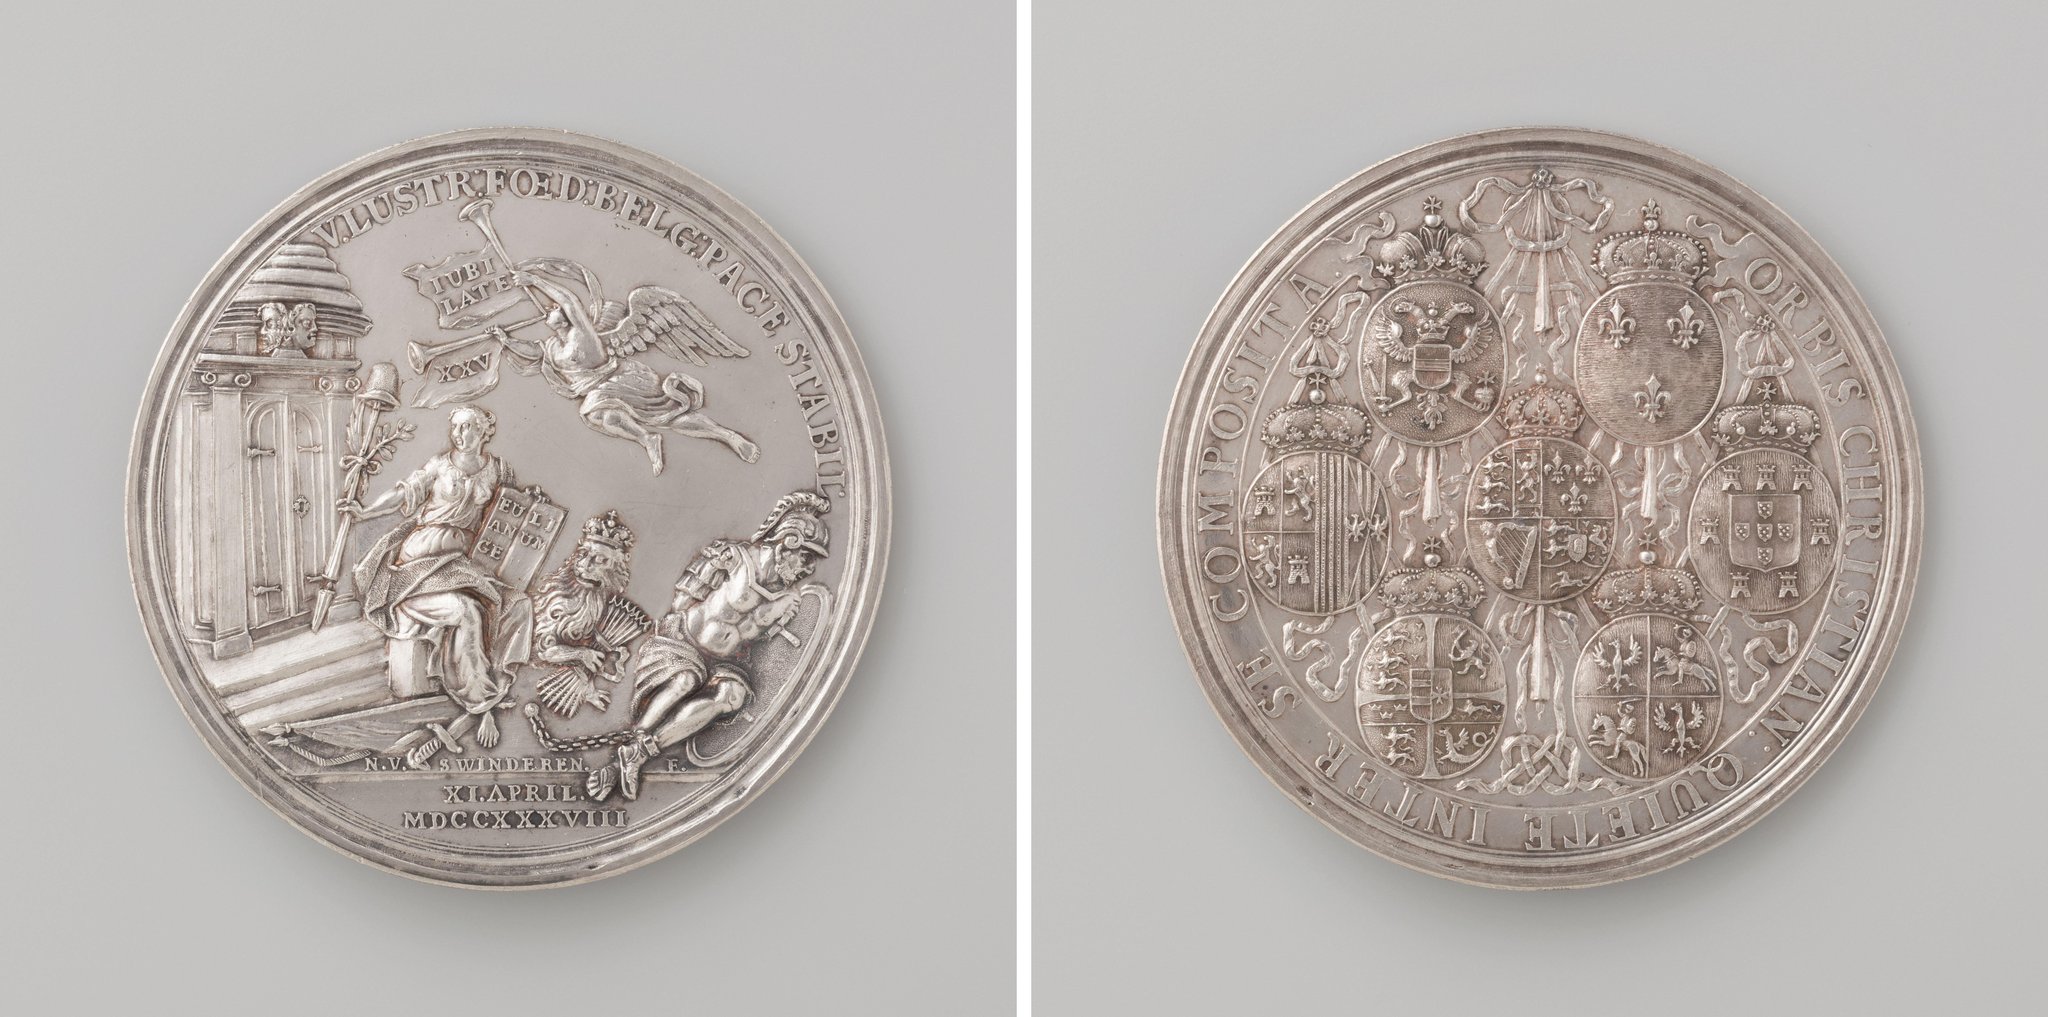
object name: history medal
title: Sedert vijfentwintig jaar vrede in de Nederlanden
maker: nicolaas van swinderen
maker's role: jeweler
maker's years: 1705-1760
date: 1738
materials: silver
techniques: striking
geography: amsterdam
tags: netherlands